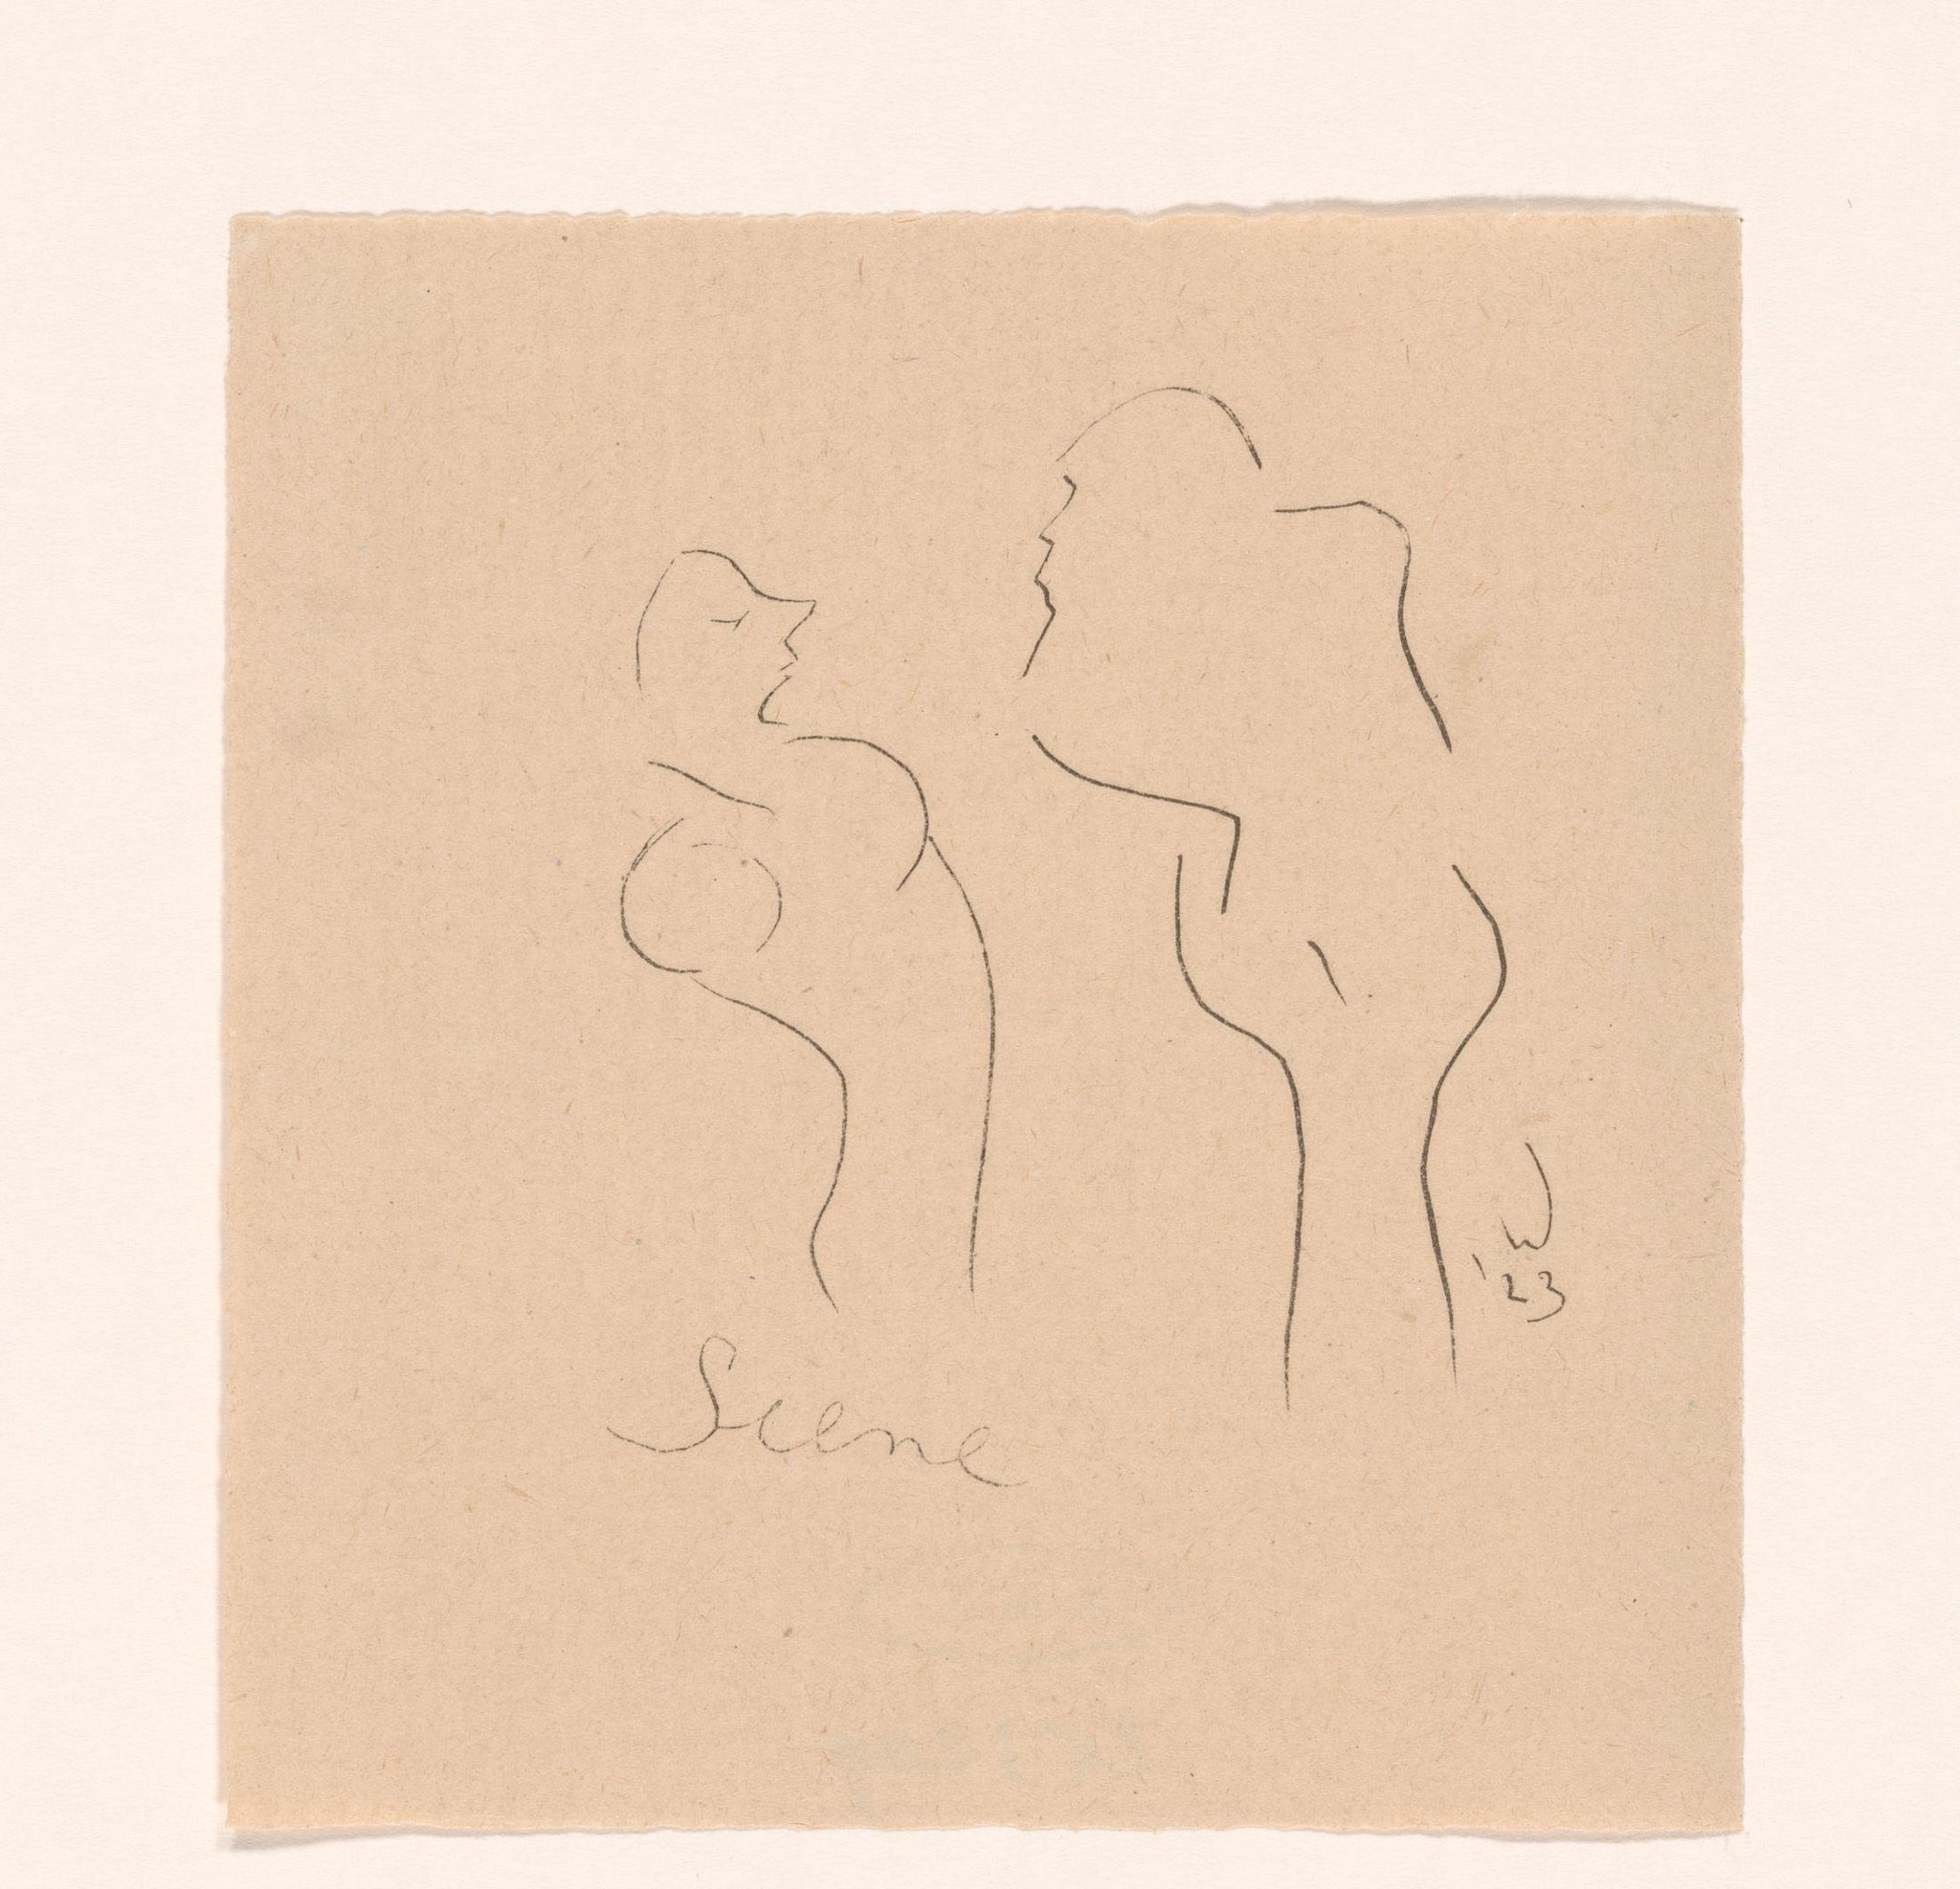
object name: print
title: Scene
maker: erich wichmann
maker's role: print maker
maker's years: 1890-1929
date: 1923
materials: paper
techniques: lithograph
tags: caricatures (human types)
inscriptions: collector's mark: Lugt 2228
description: De contouren van twee figuren die tegenover elkaar staan.